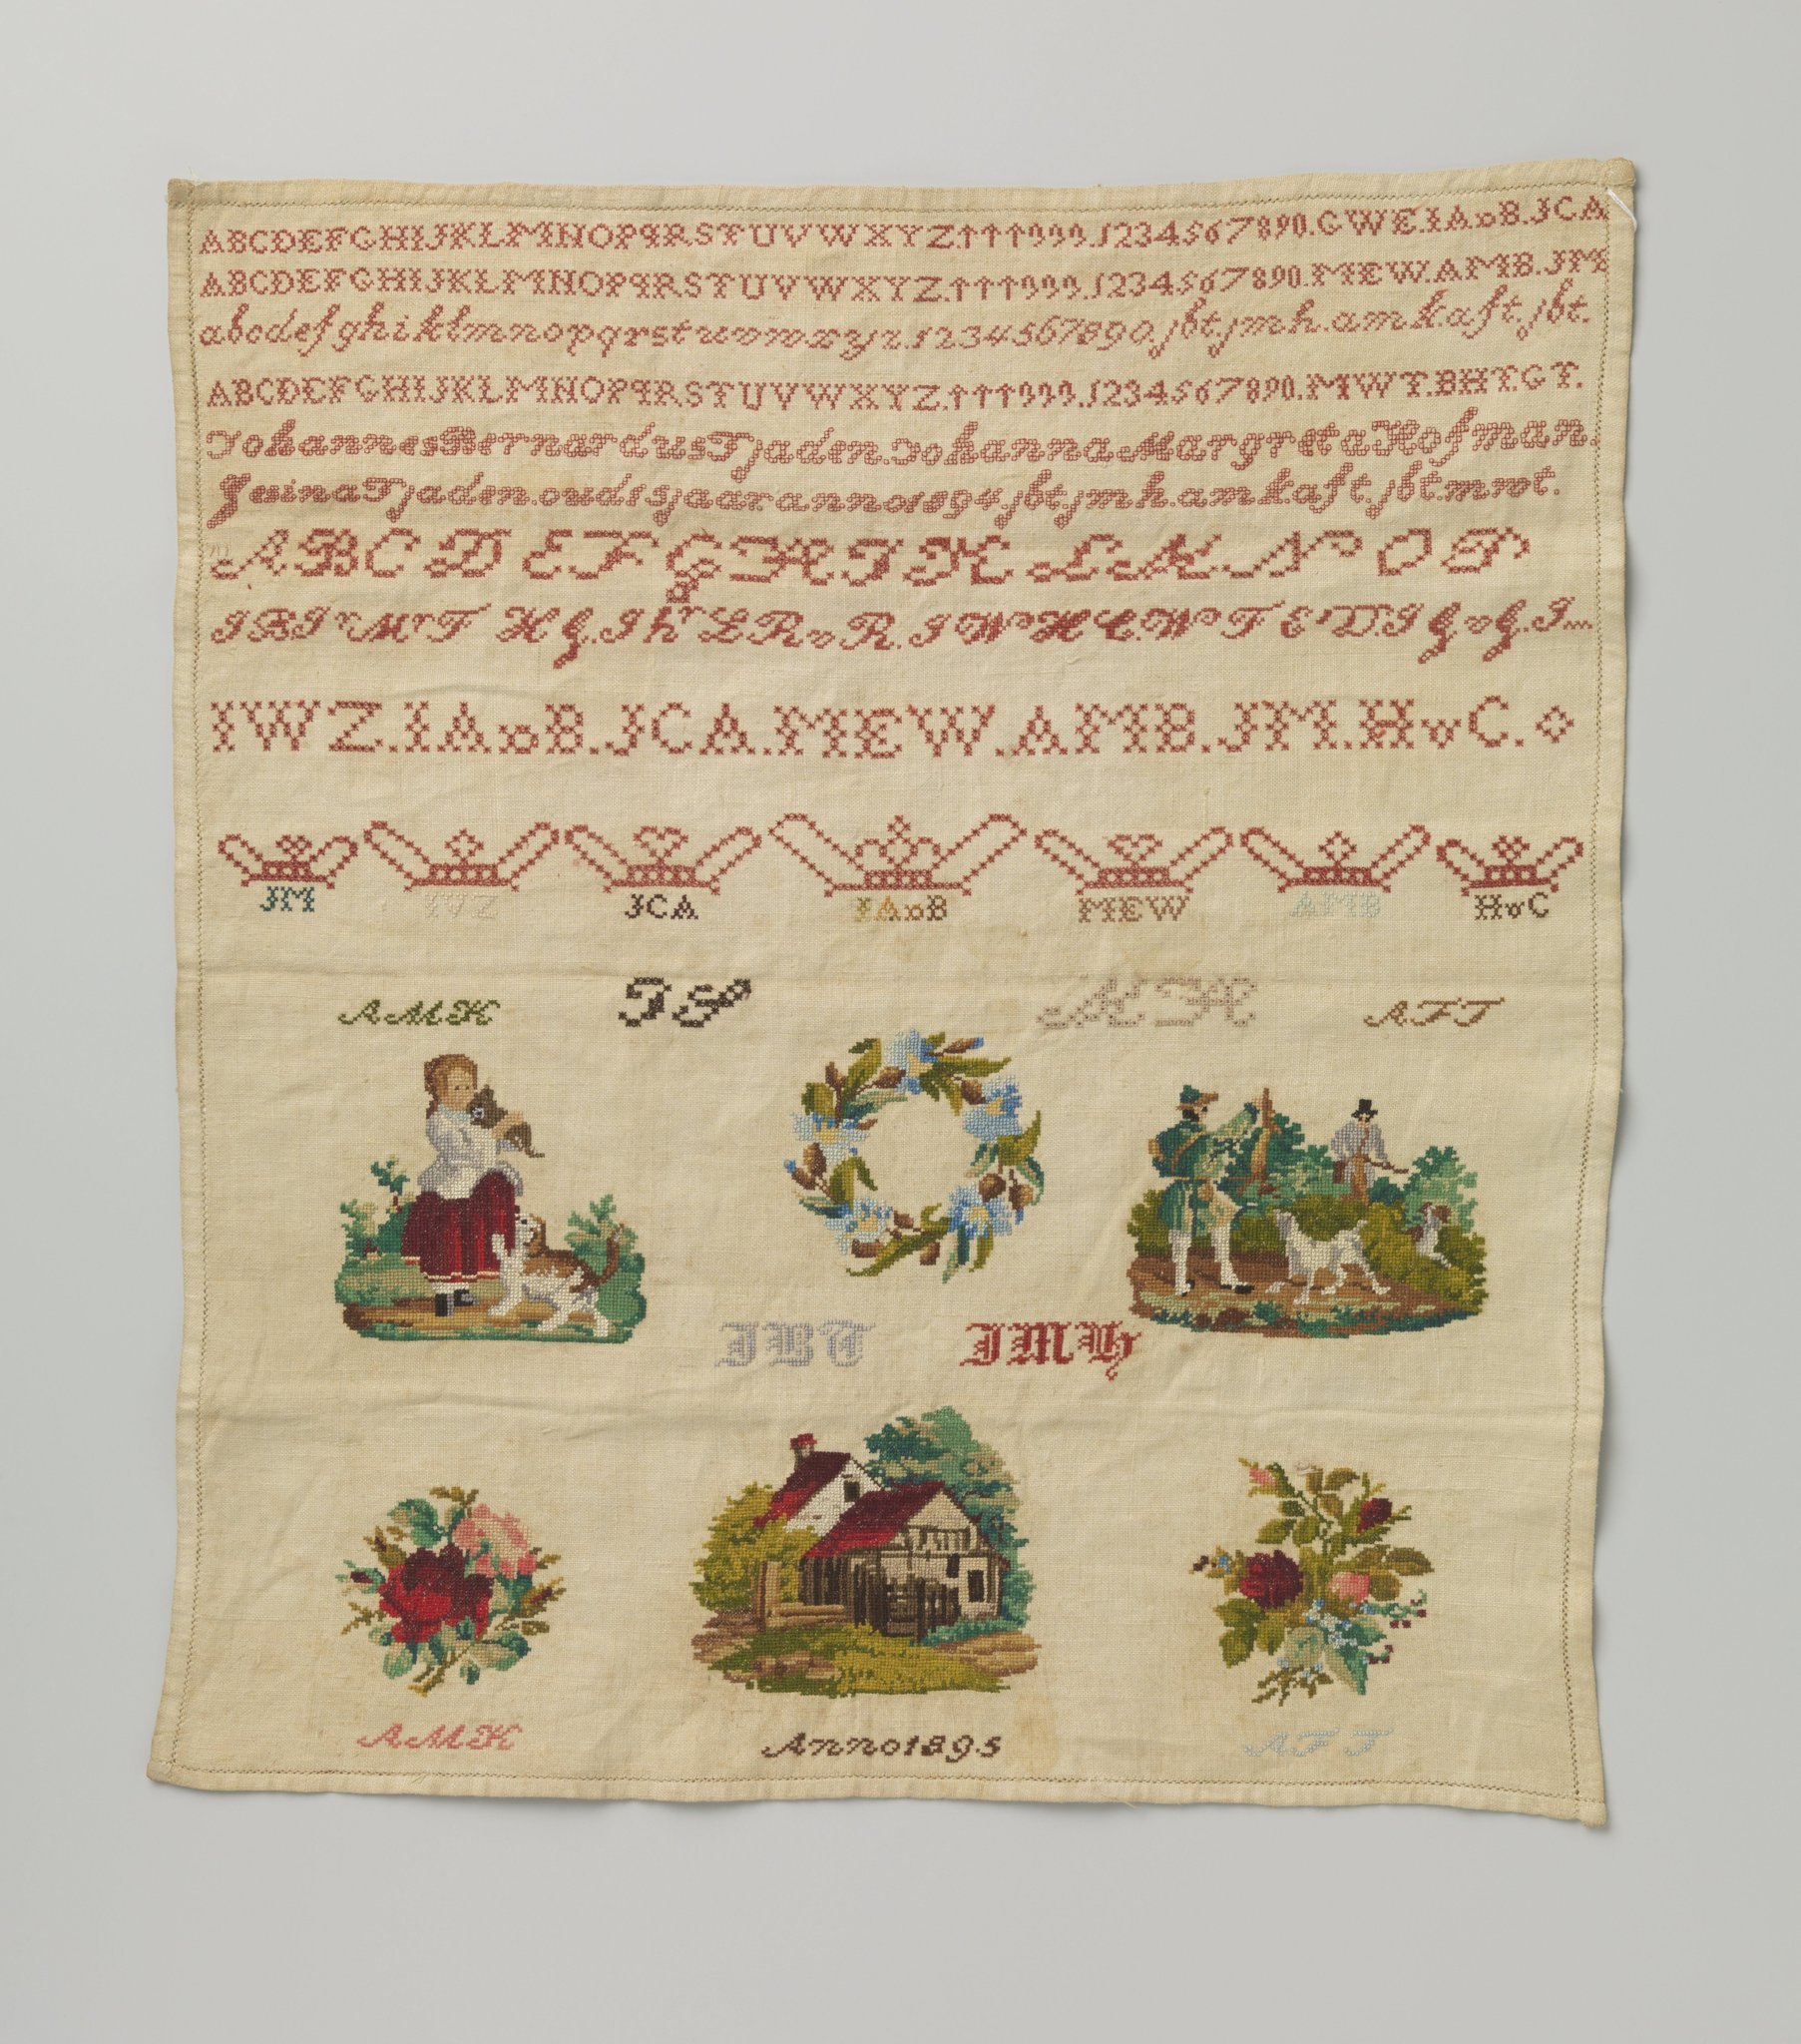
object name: merkdoek, merklap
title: Merklap van veelkleurige zijde op katoen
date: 1894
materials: cotton, silk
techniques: embroidered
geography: amsterdam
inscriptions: date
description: Merklap van zijde op katoen. Het borduurwerk bestaat uit enige malen het alfabet, en de cijfers, een rij initialen, de namen J.B. TJADEN, J.M. HOFMAN EN G. TJADEN en het jaartal ANNO 1894.